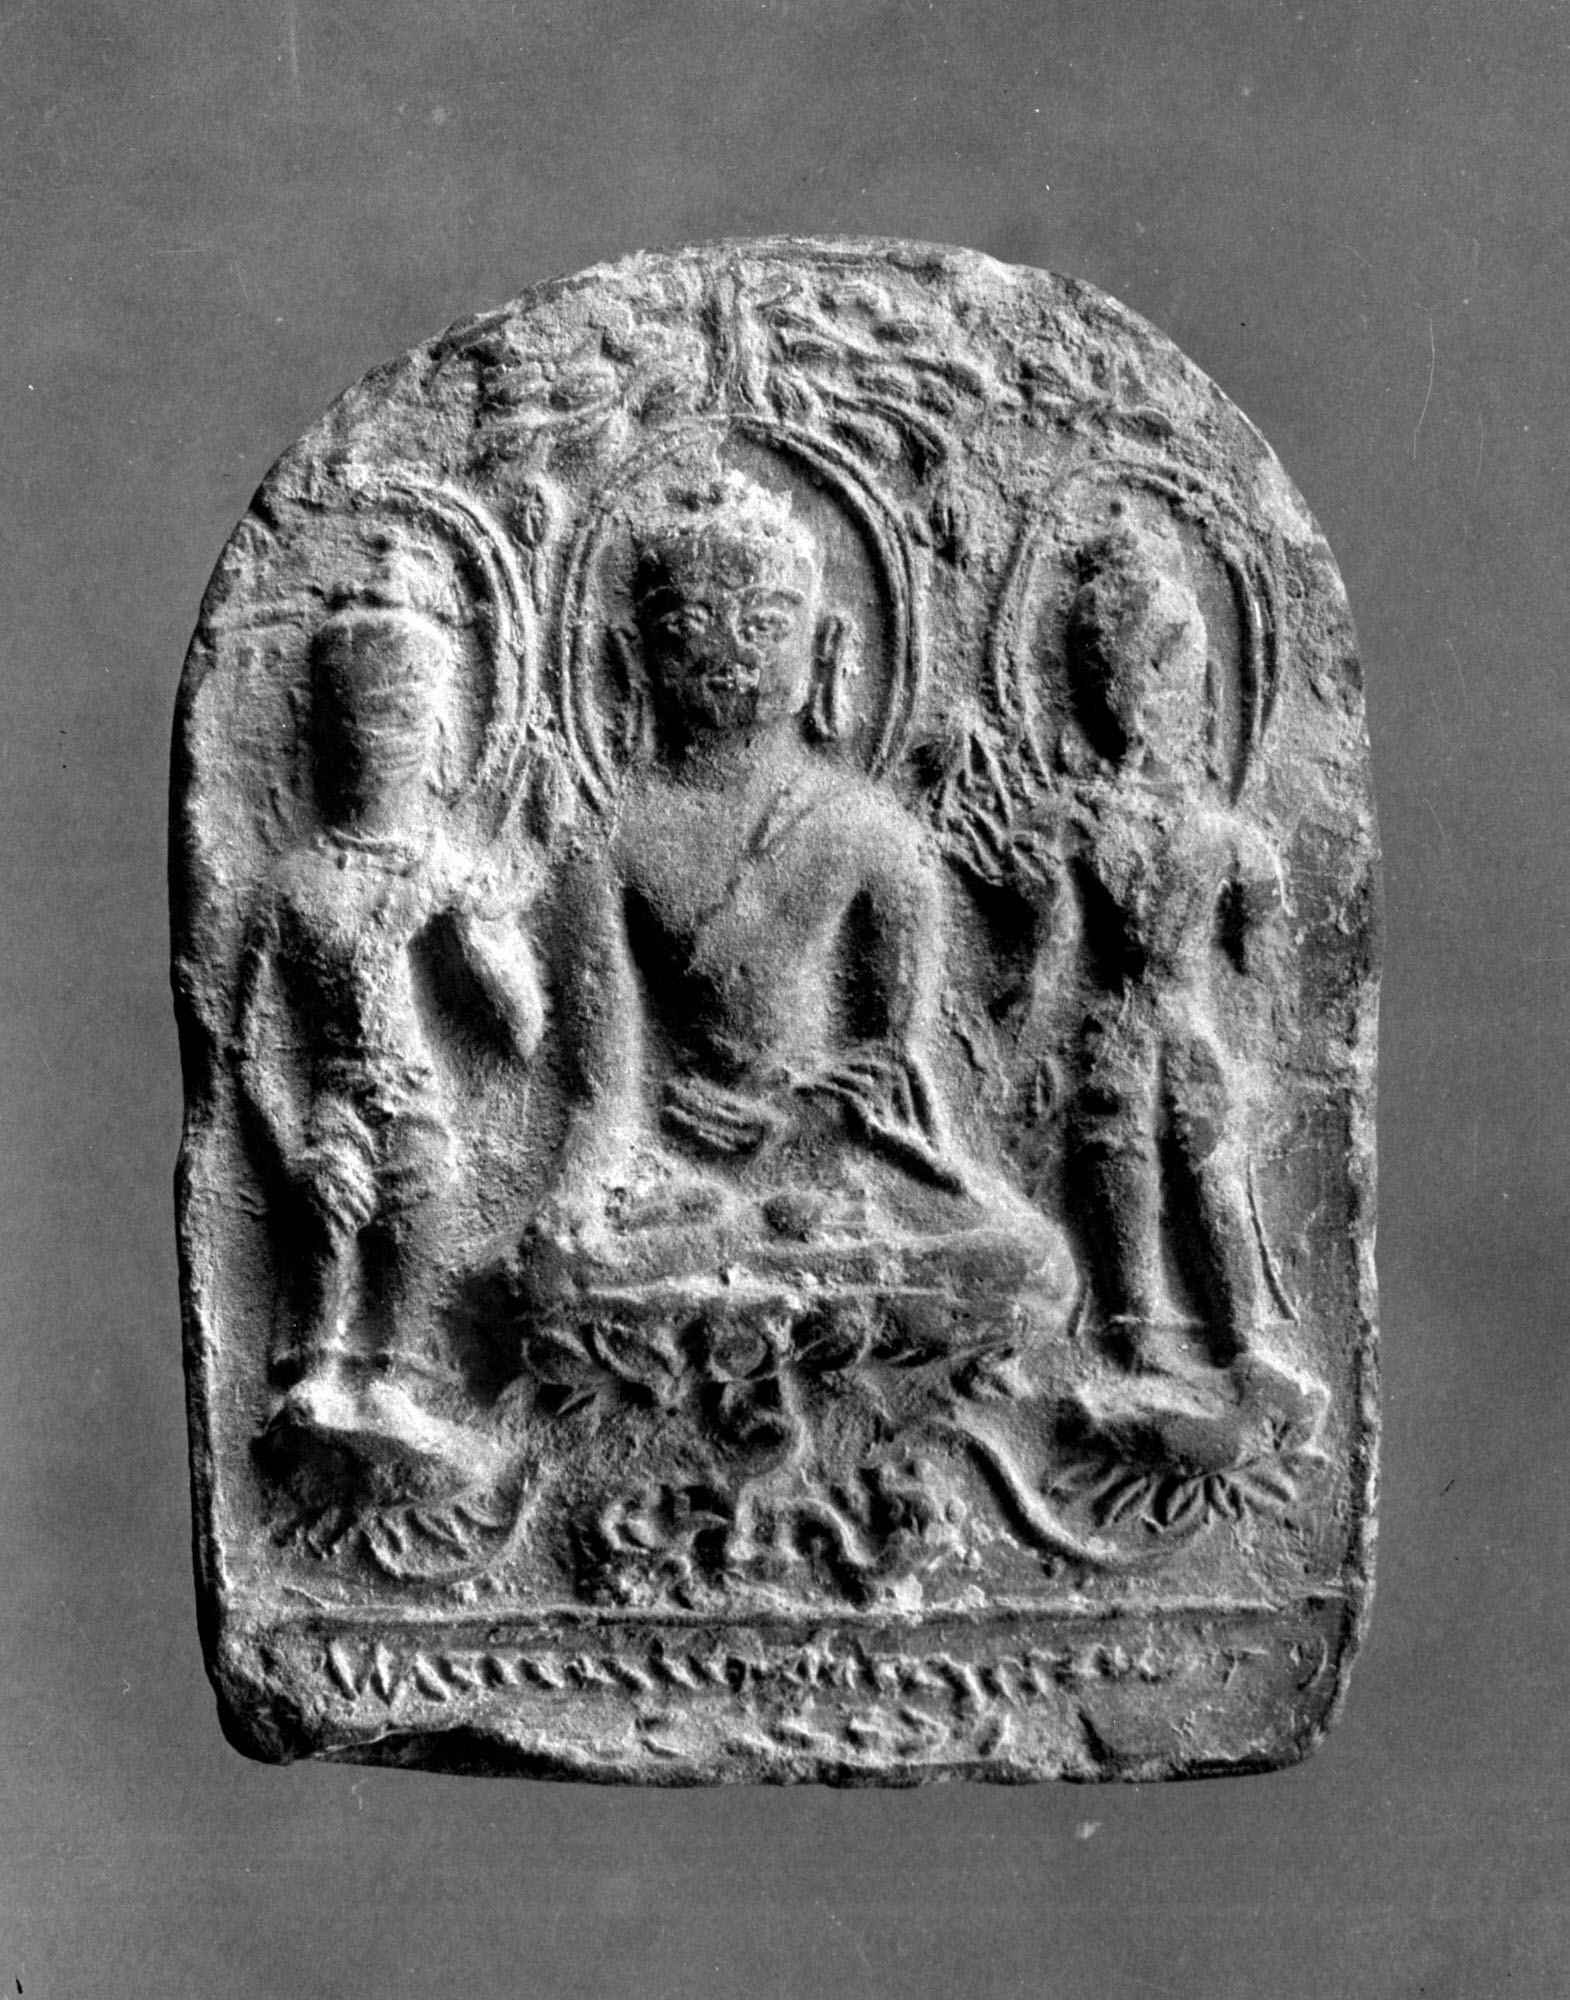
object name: tile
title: Tile with Buddhist Trinity in Relief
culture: chinese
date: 618-907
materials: clay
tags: buddhism,buddha